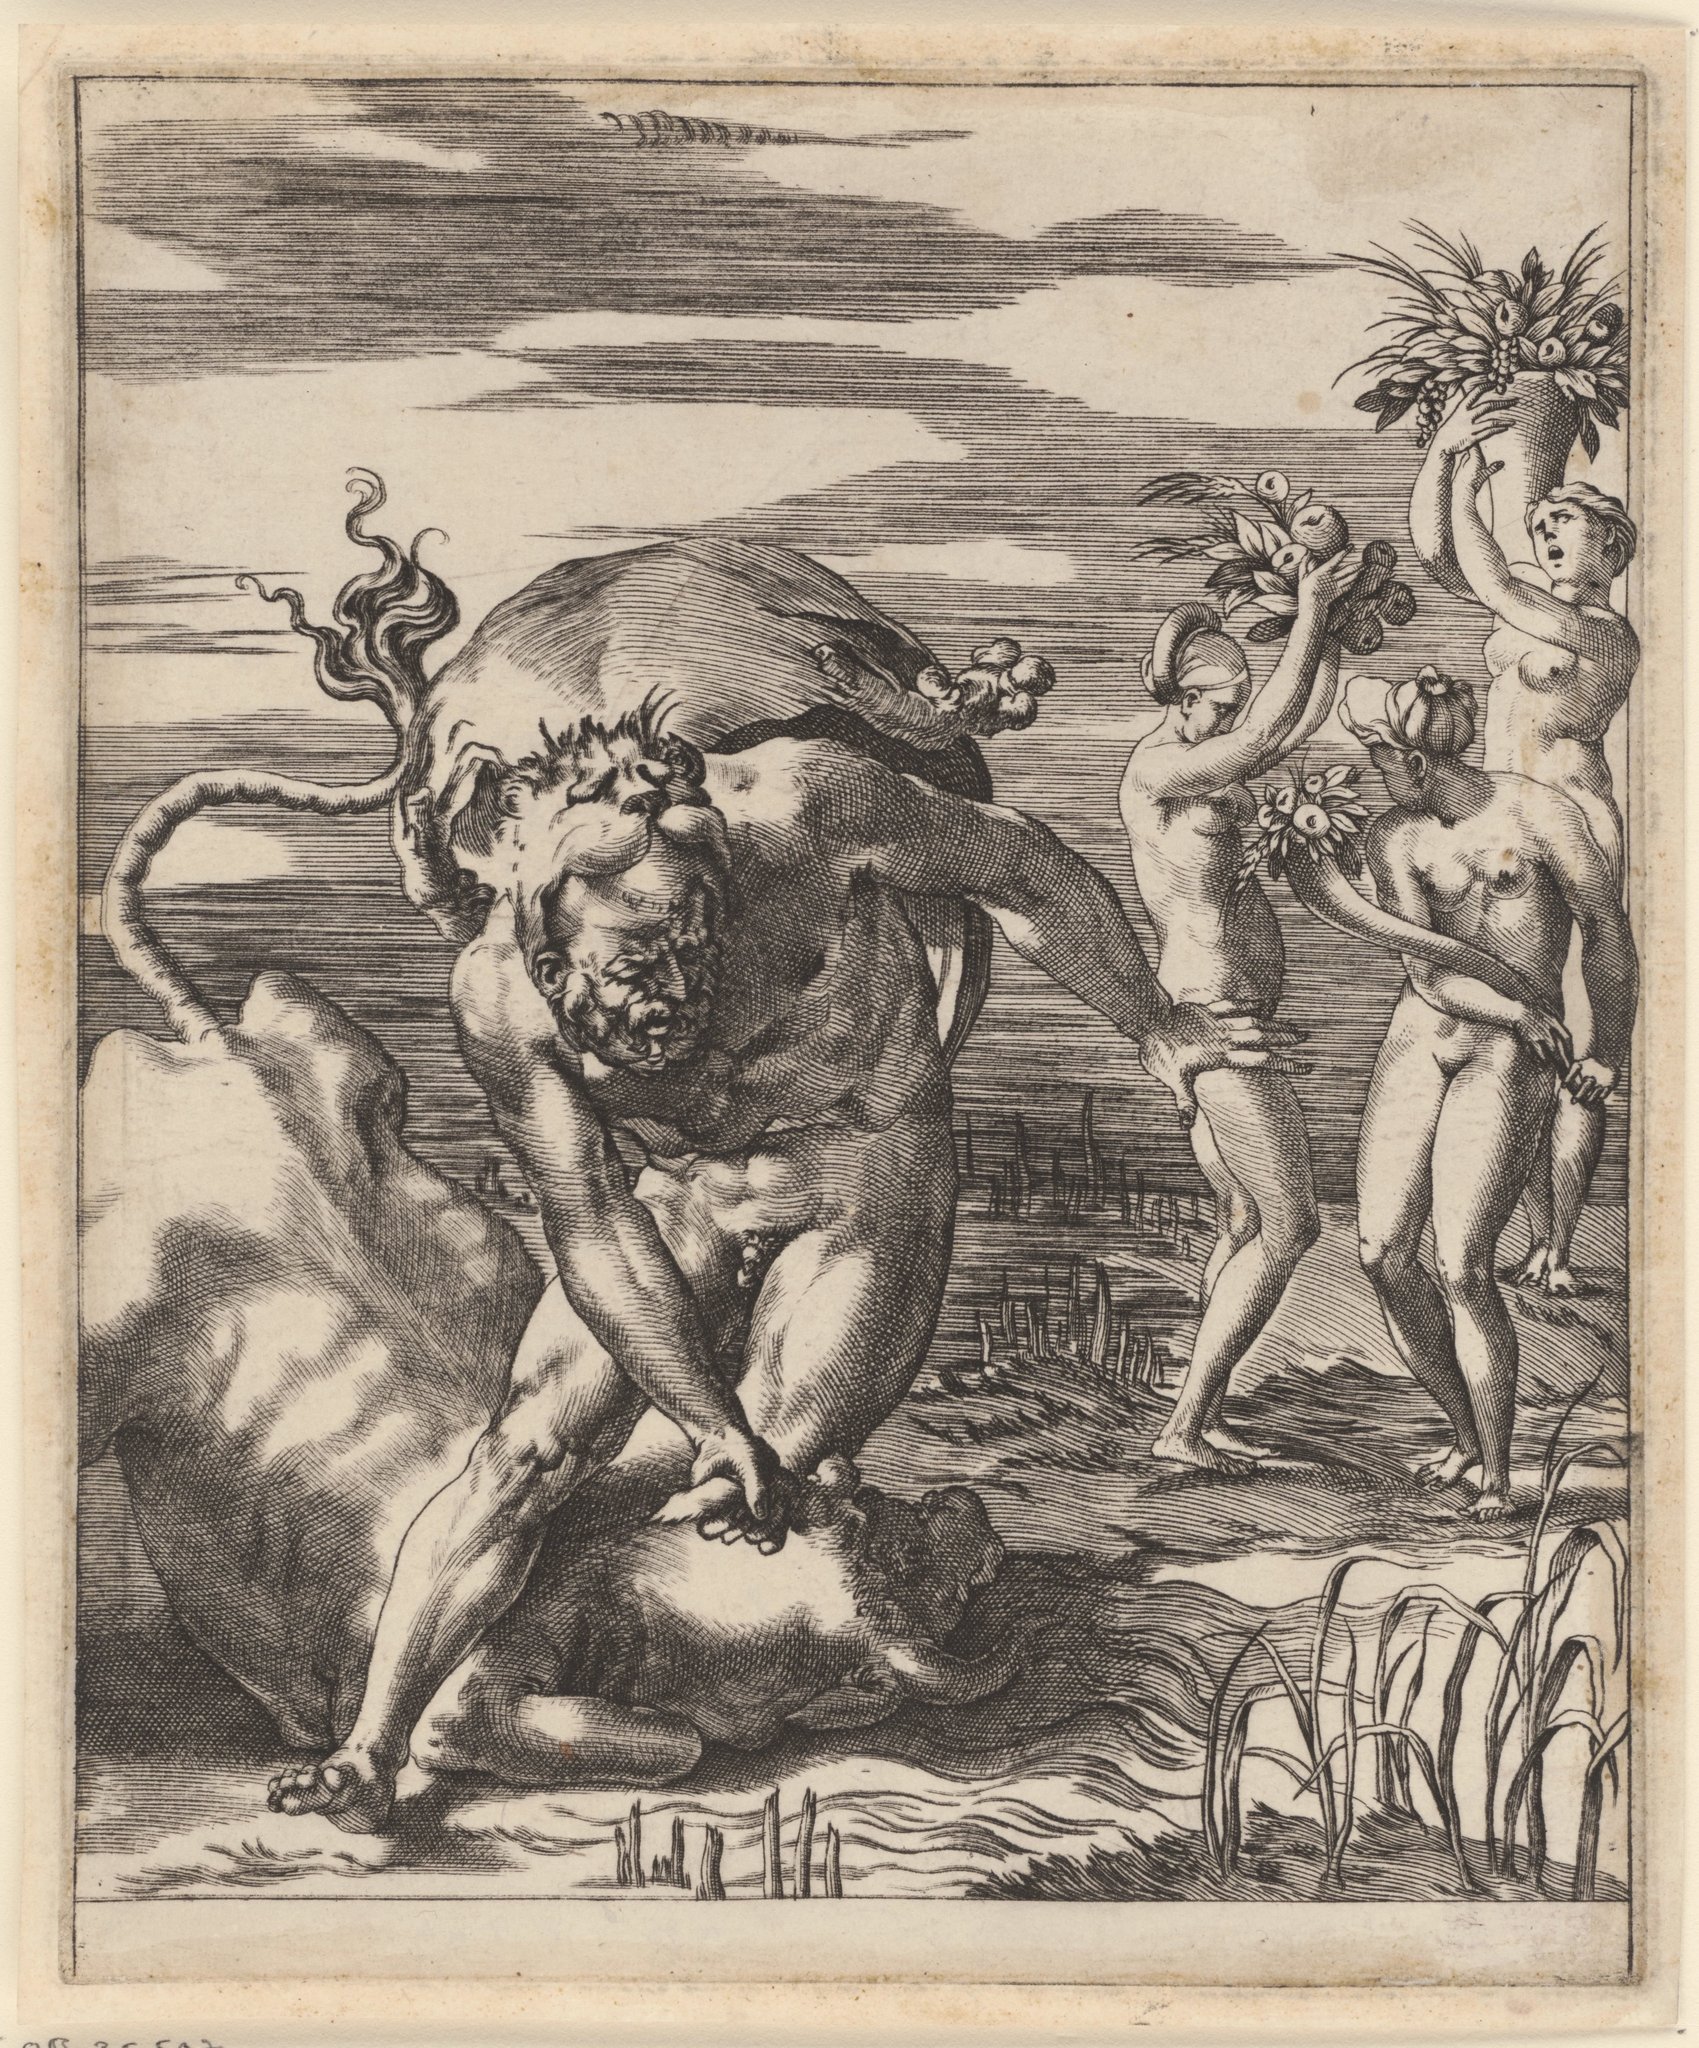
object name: print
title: Hercules worstelt met Acheloüs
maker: giovanni jacopo caraglio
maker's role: goldsmith, print maker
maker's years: 1500-1565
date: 1515-1565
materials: paper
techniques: engraving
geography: italy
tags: while fighting with hercules the river-god achelous changes himself into a bull, or a bull-headed man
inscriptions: collector's mark: Lugt 240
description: Hercules in gevecht met de riviergod Acheloüs om Deïanira, de dochter van de riviergod Oeneus. Acheloüs heeft de gedaante aangenomen van een stier. Op de achtergrond een groep nimfen.